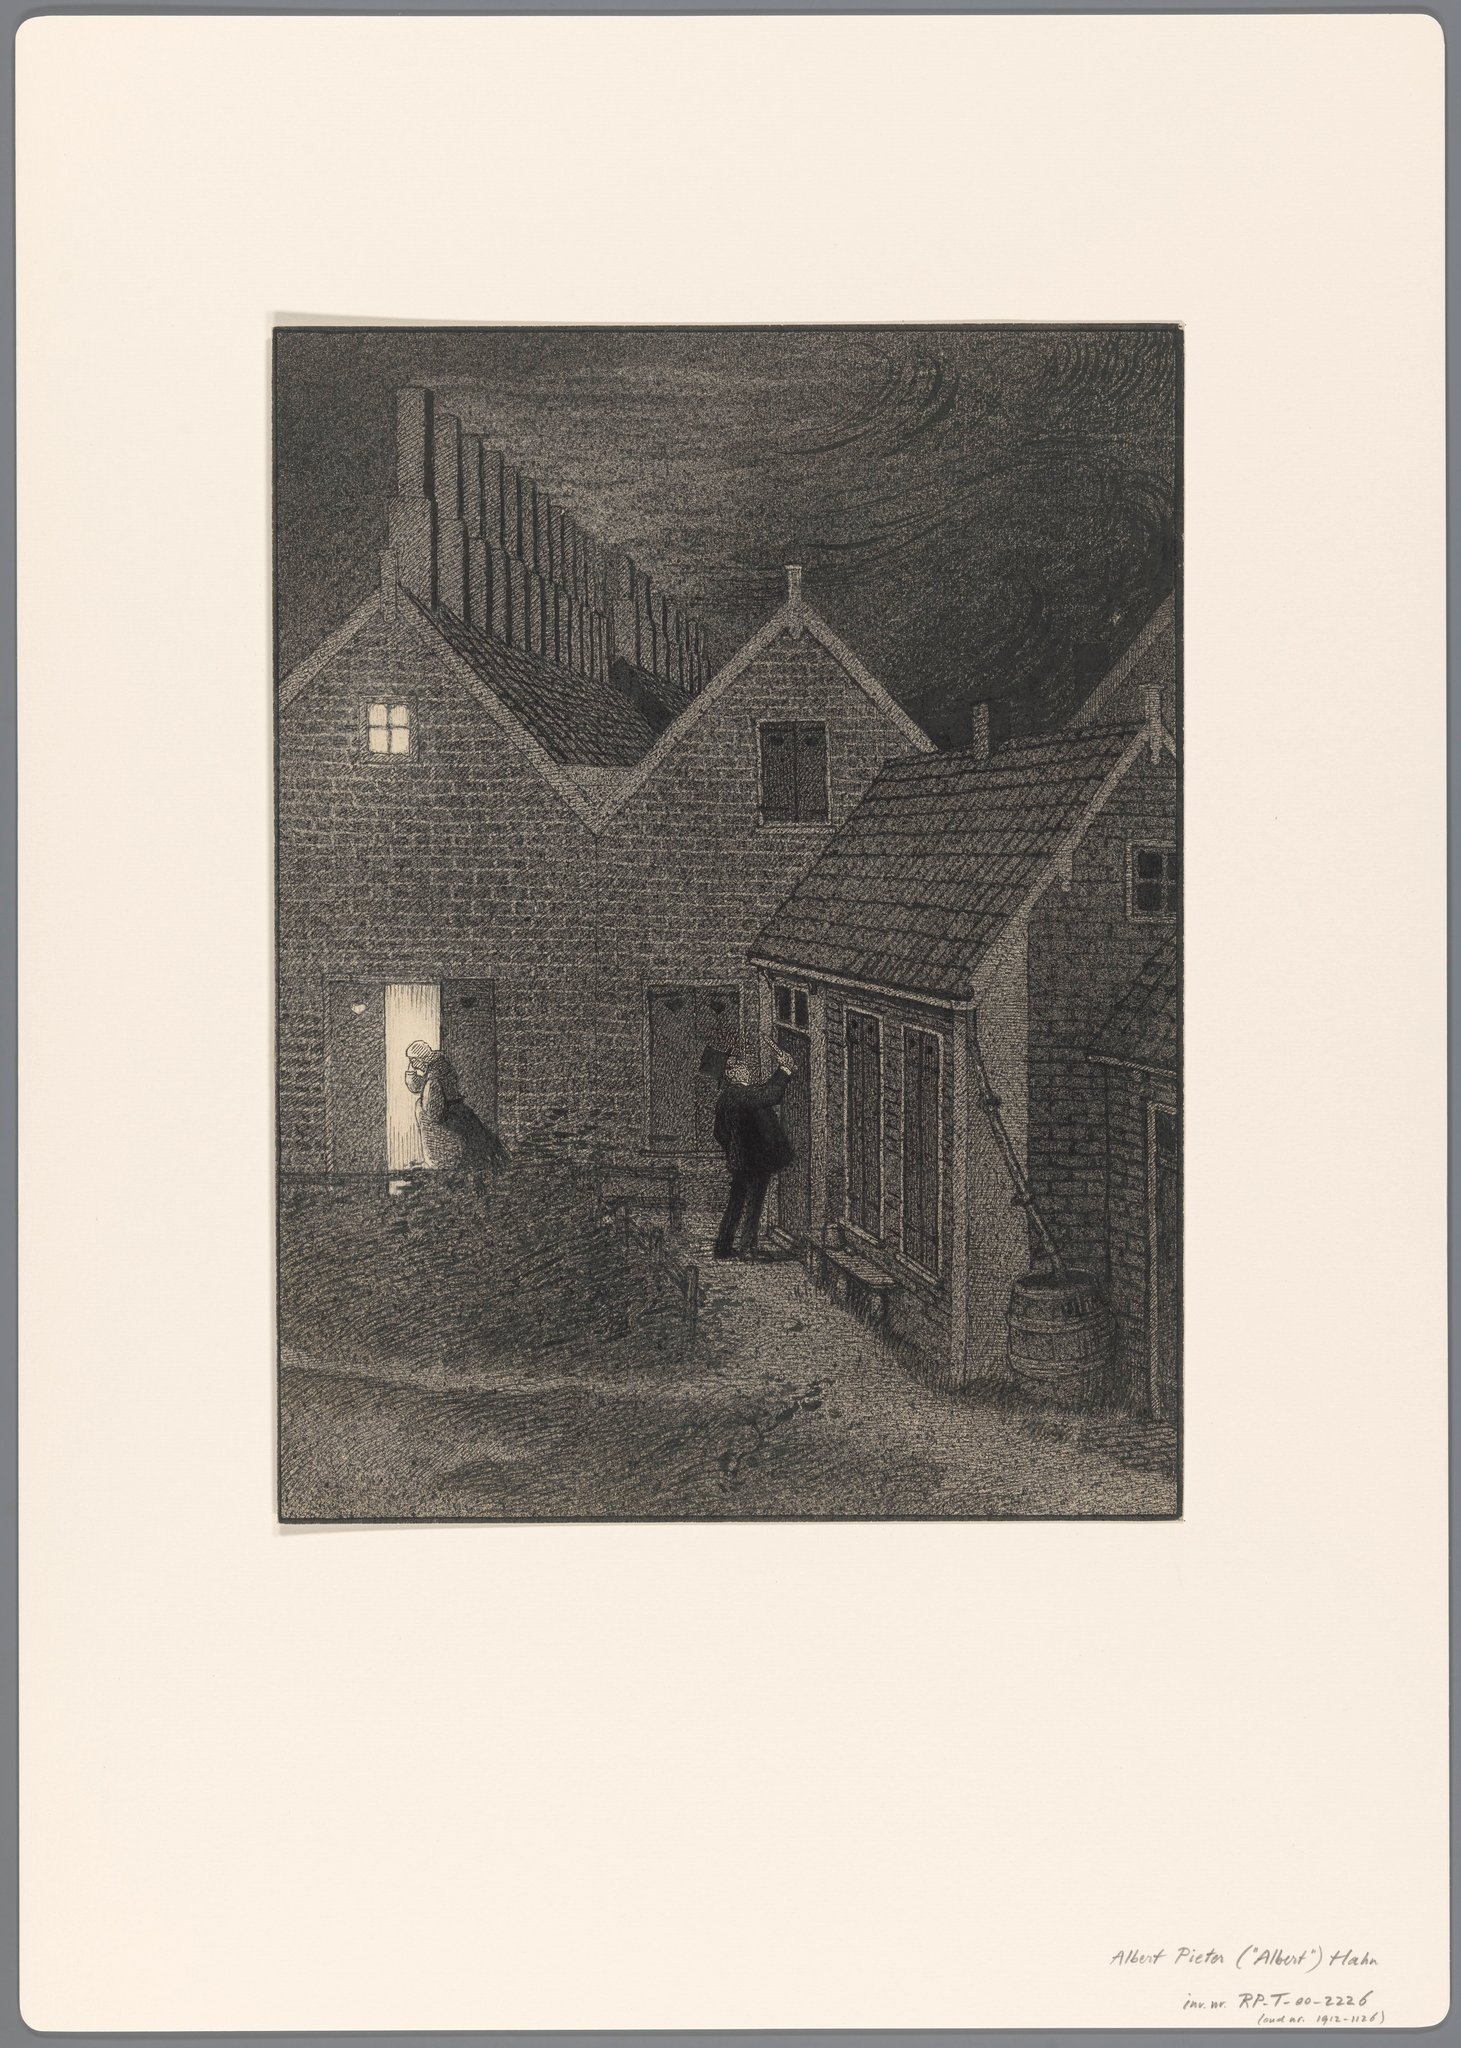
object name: drawing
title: Ontwerp voor een politieke spotprent: de aanzegger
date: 1887-1918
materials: cardboard, ink, pencil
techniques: brush, pen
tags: political caricatures and satires